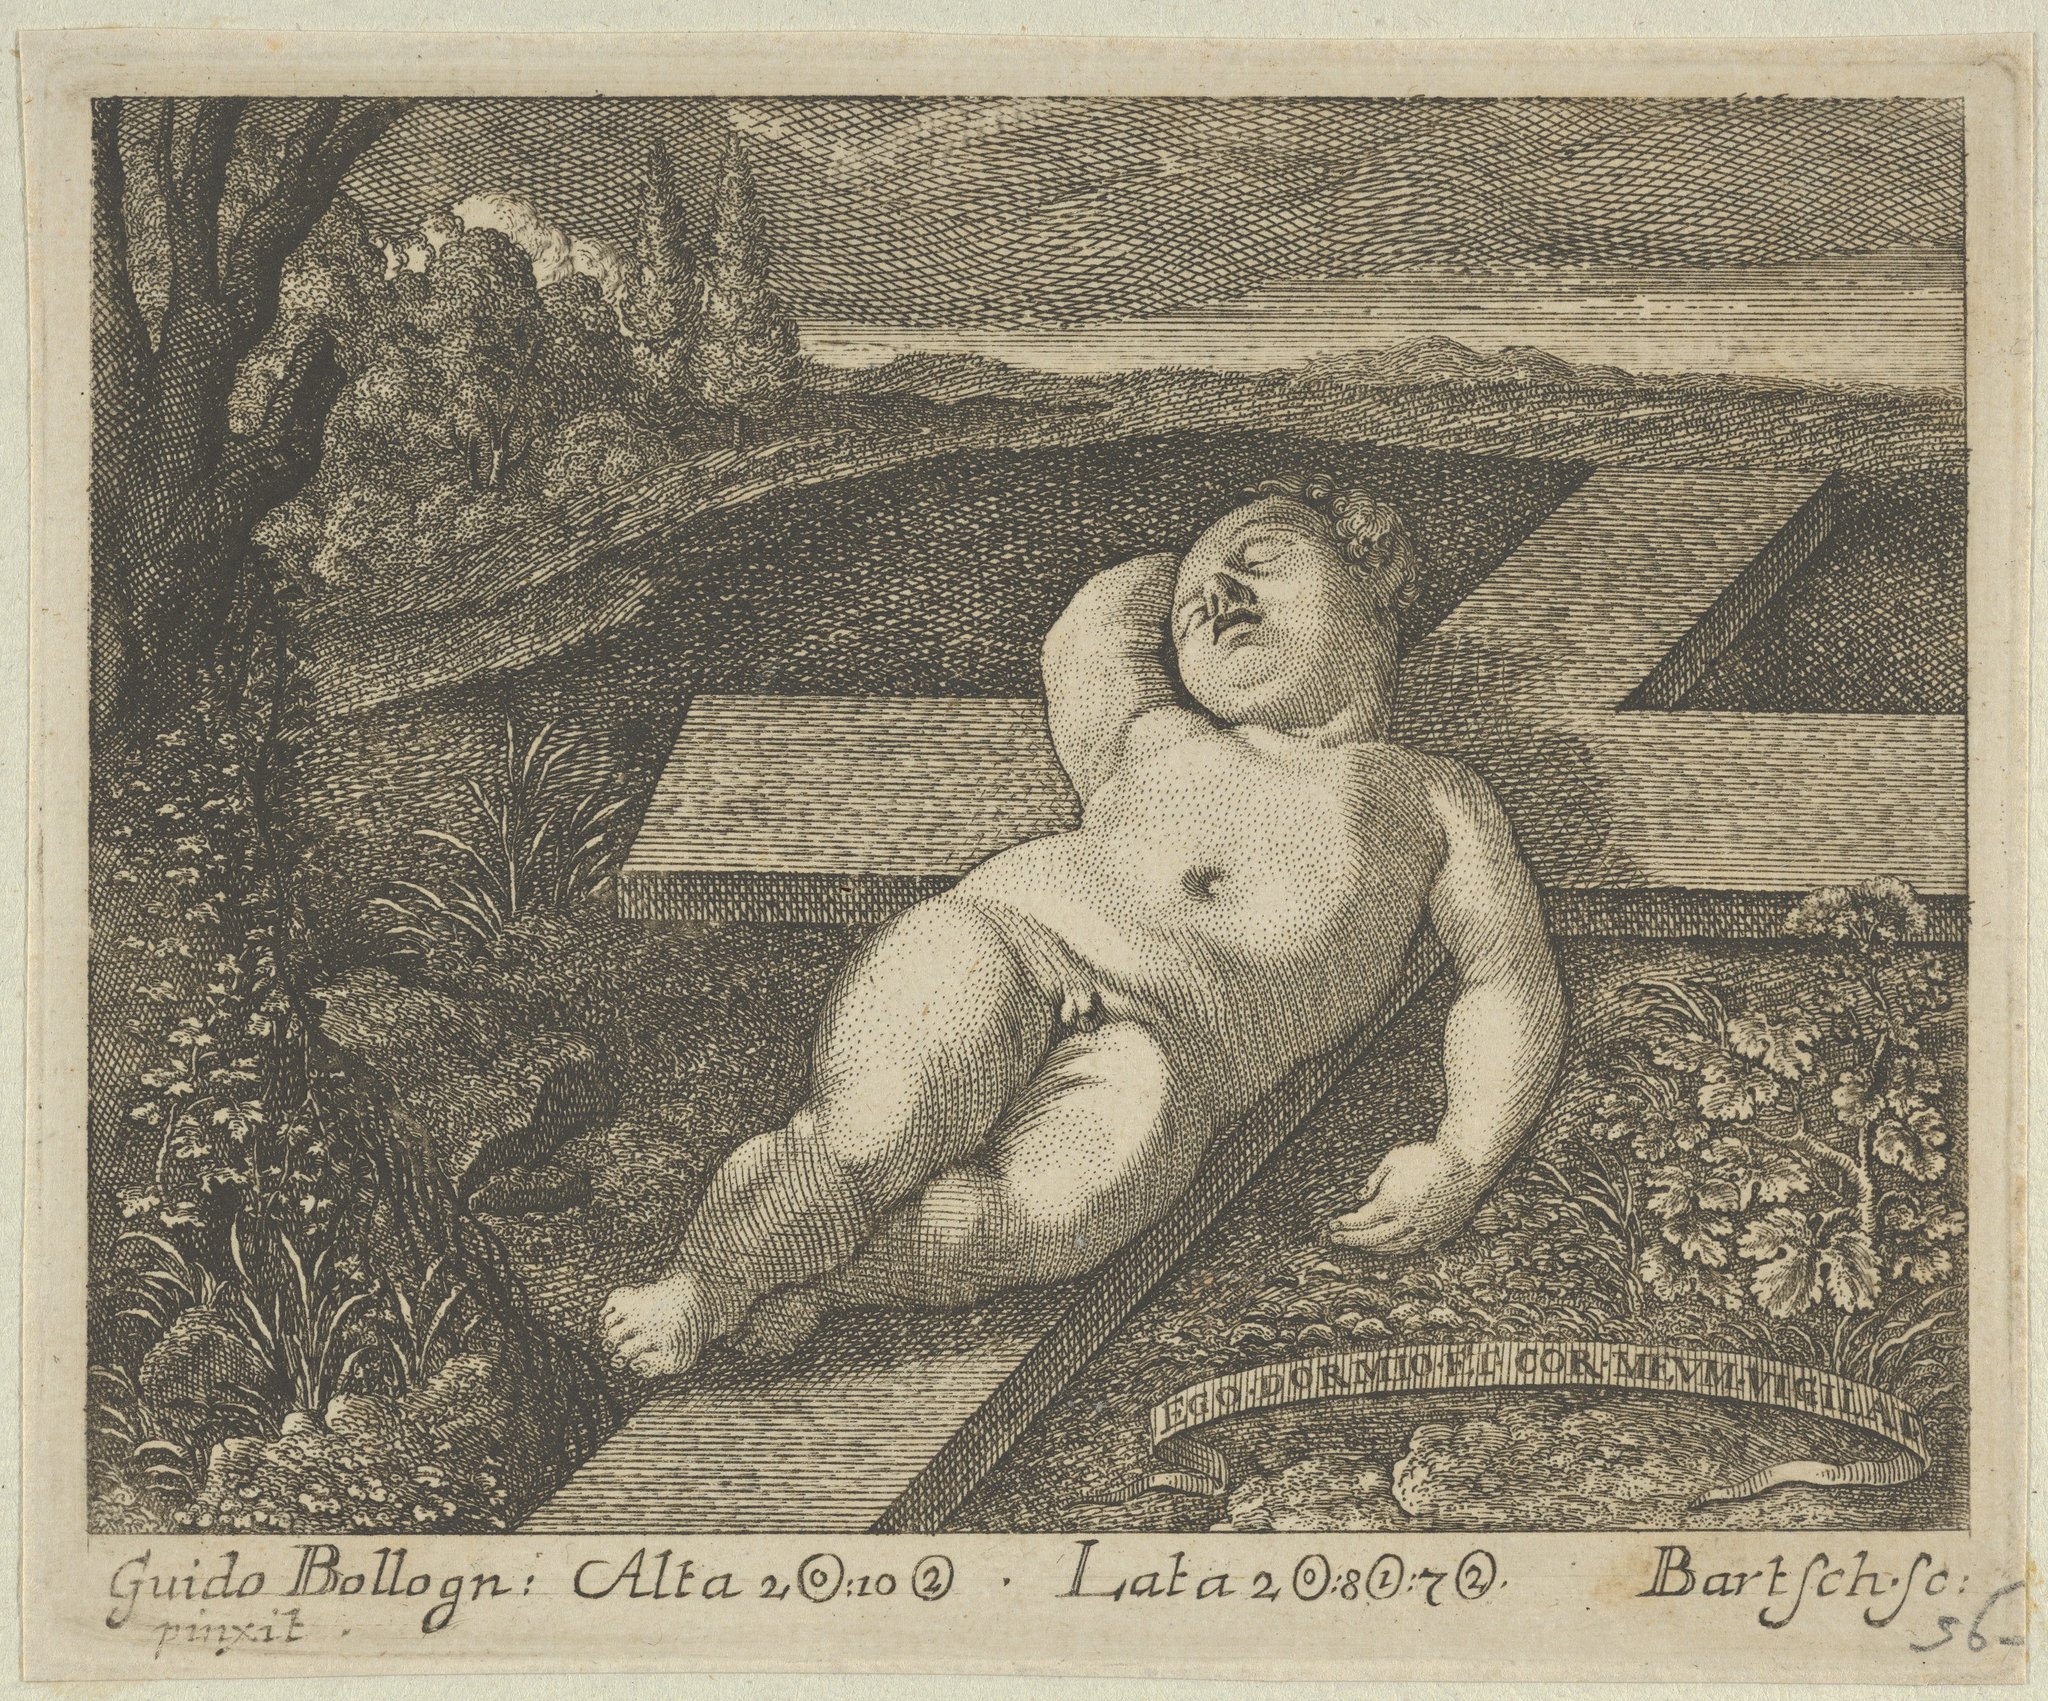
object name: print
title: The Christ Child sleeping on a cross in a landscape, after Reni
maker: johann gottfried bartsch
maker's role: engraver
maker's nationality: german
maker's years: 1620-1720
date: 1780-1821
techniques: engraving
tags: landscapes,christ,cross